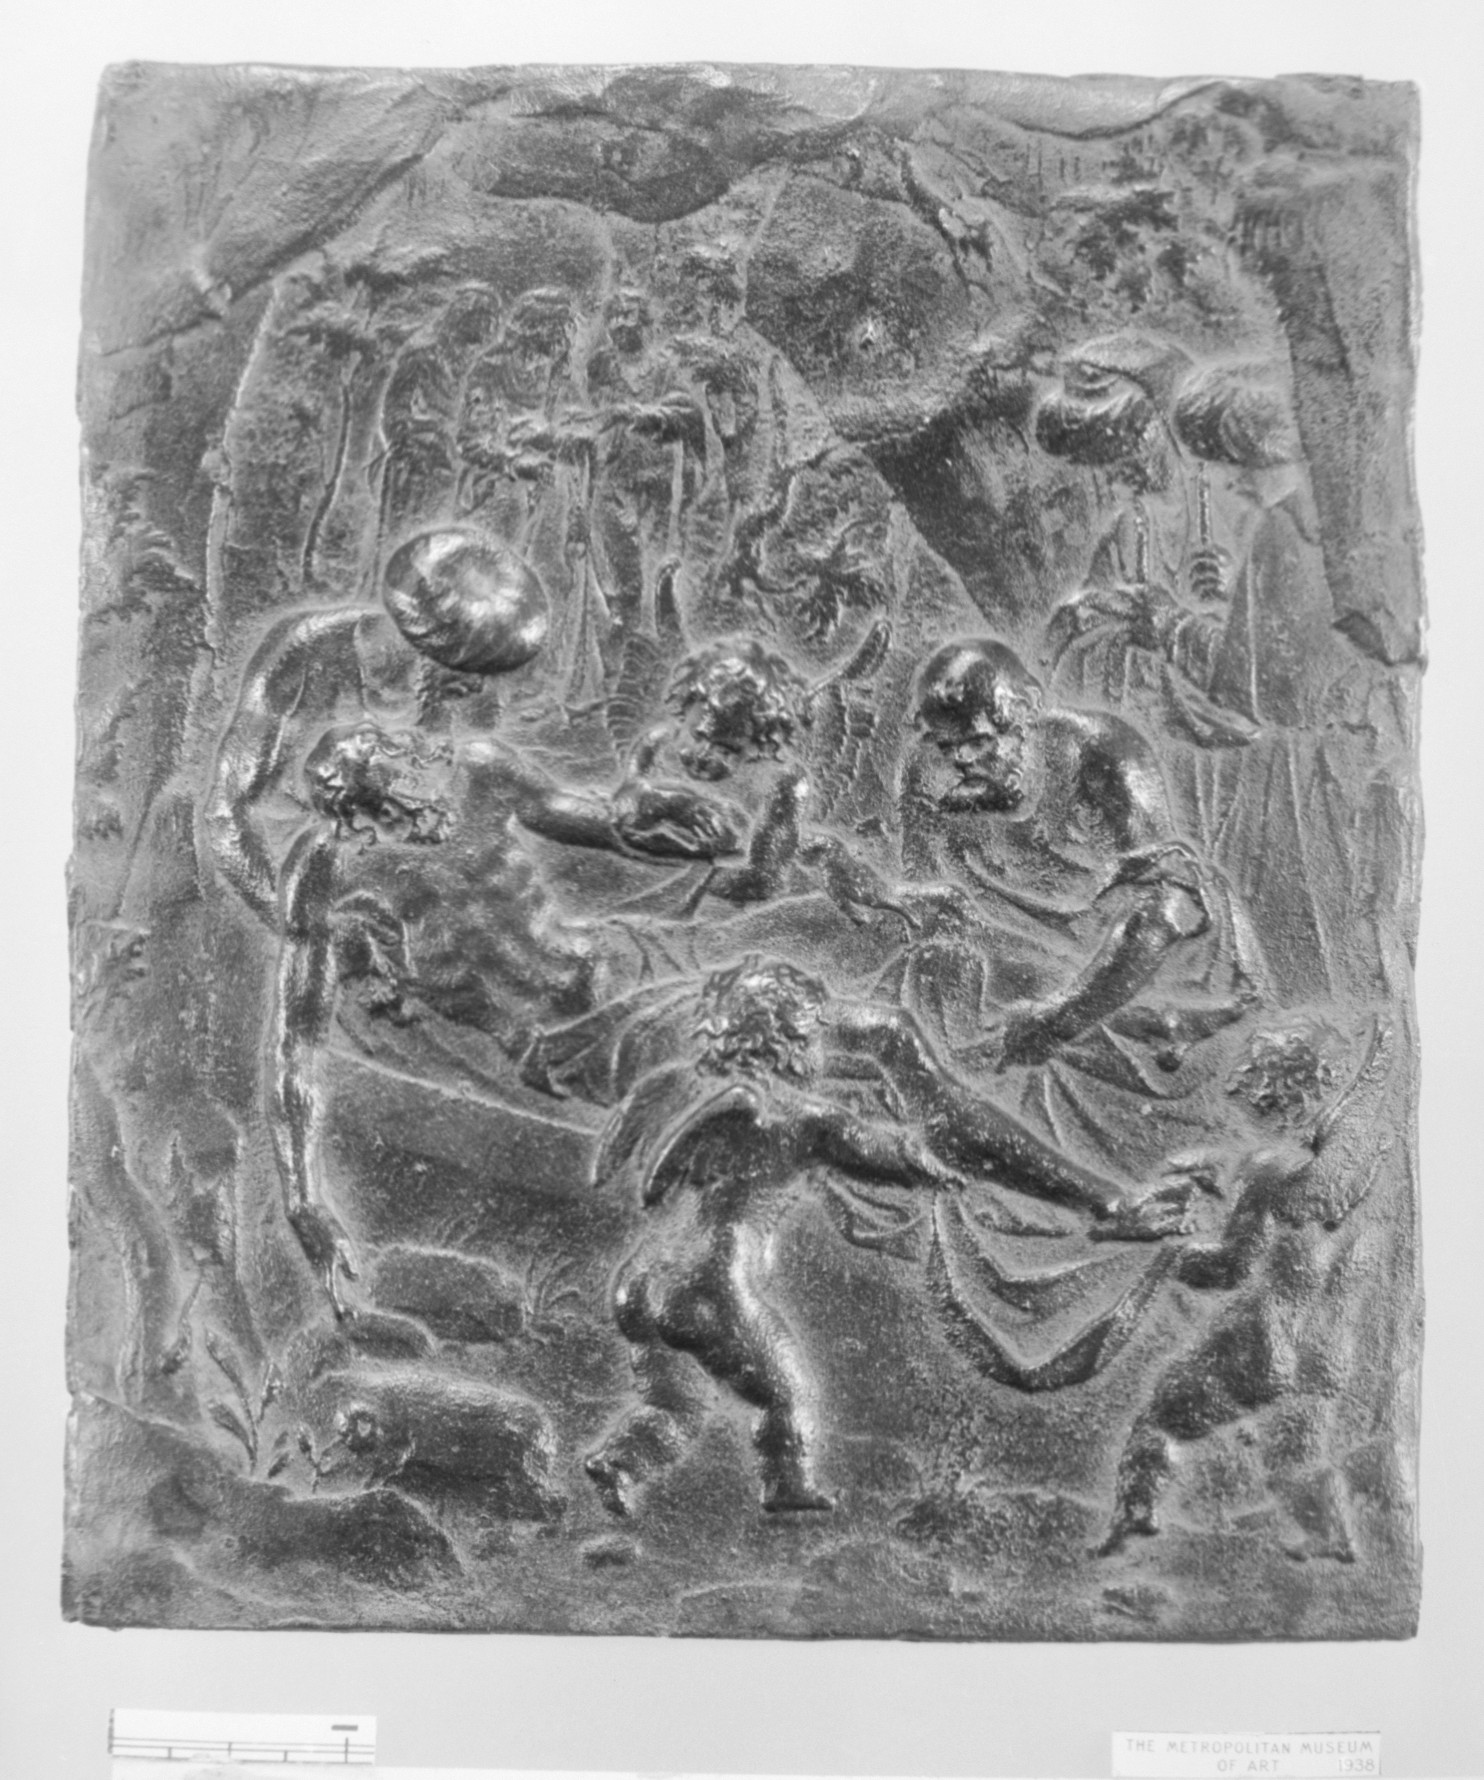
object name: plaquette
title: Entombment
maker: monogrammist cb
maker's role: artist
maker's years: 1550-1700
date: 1601-1700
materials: bronze, patina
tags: putti,entombment